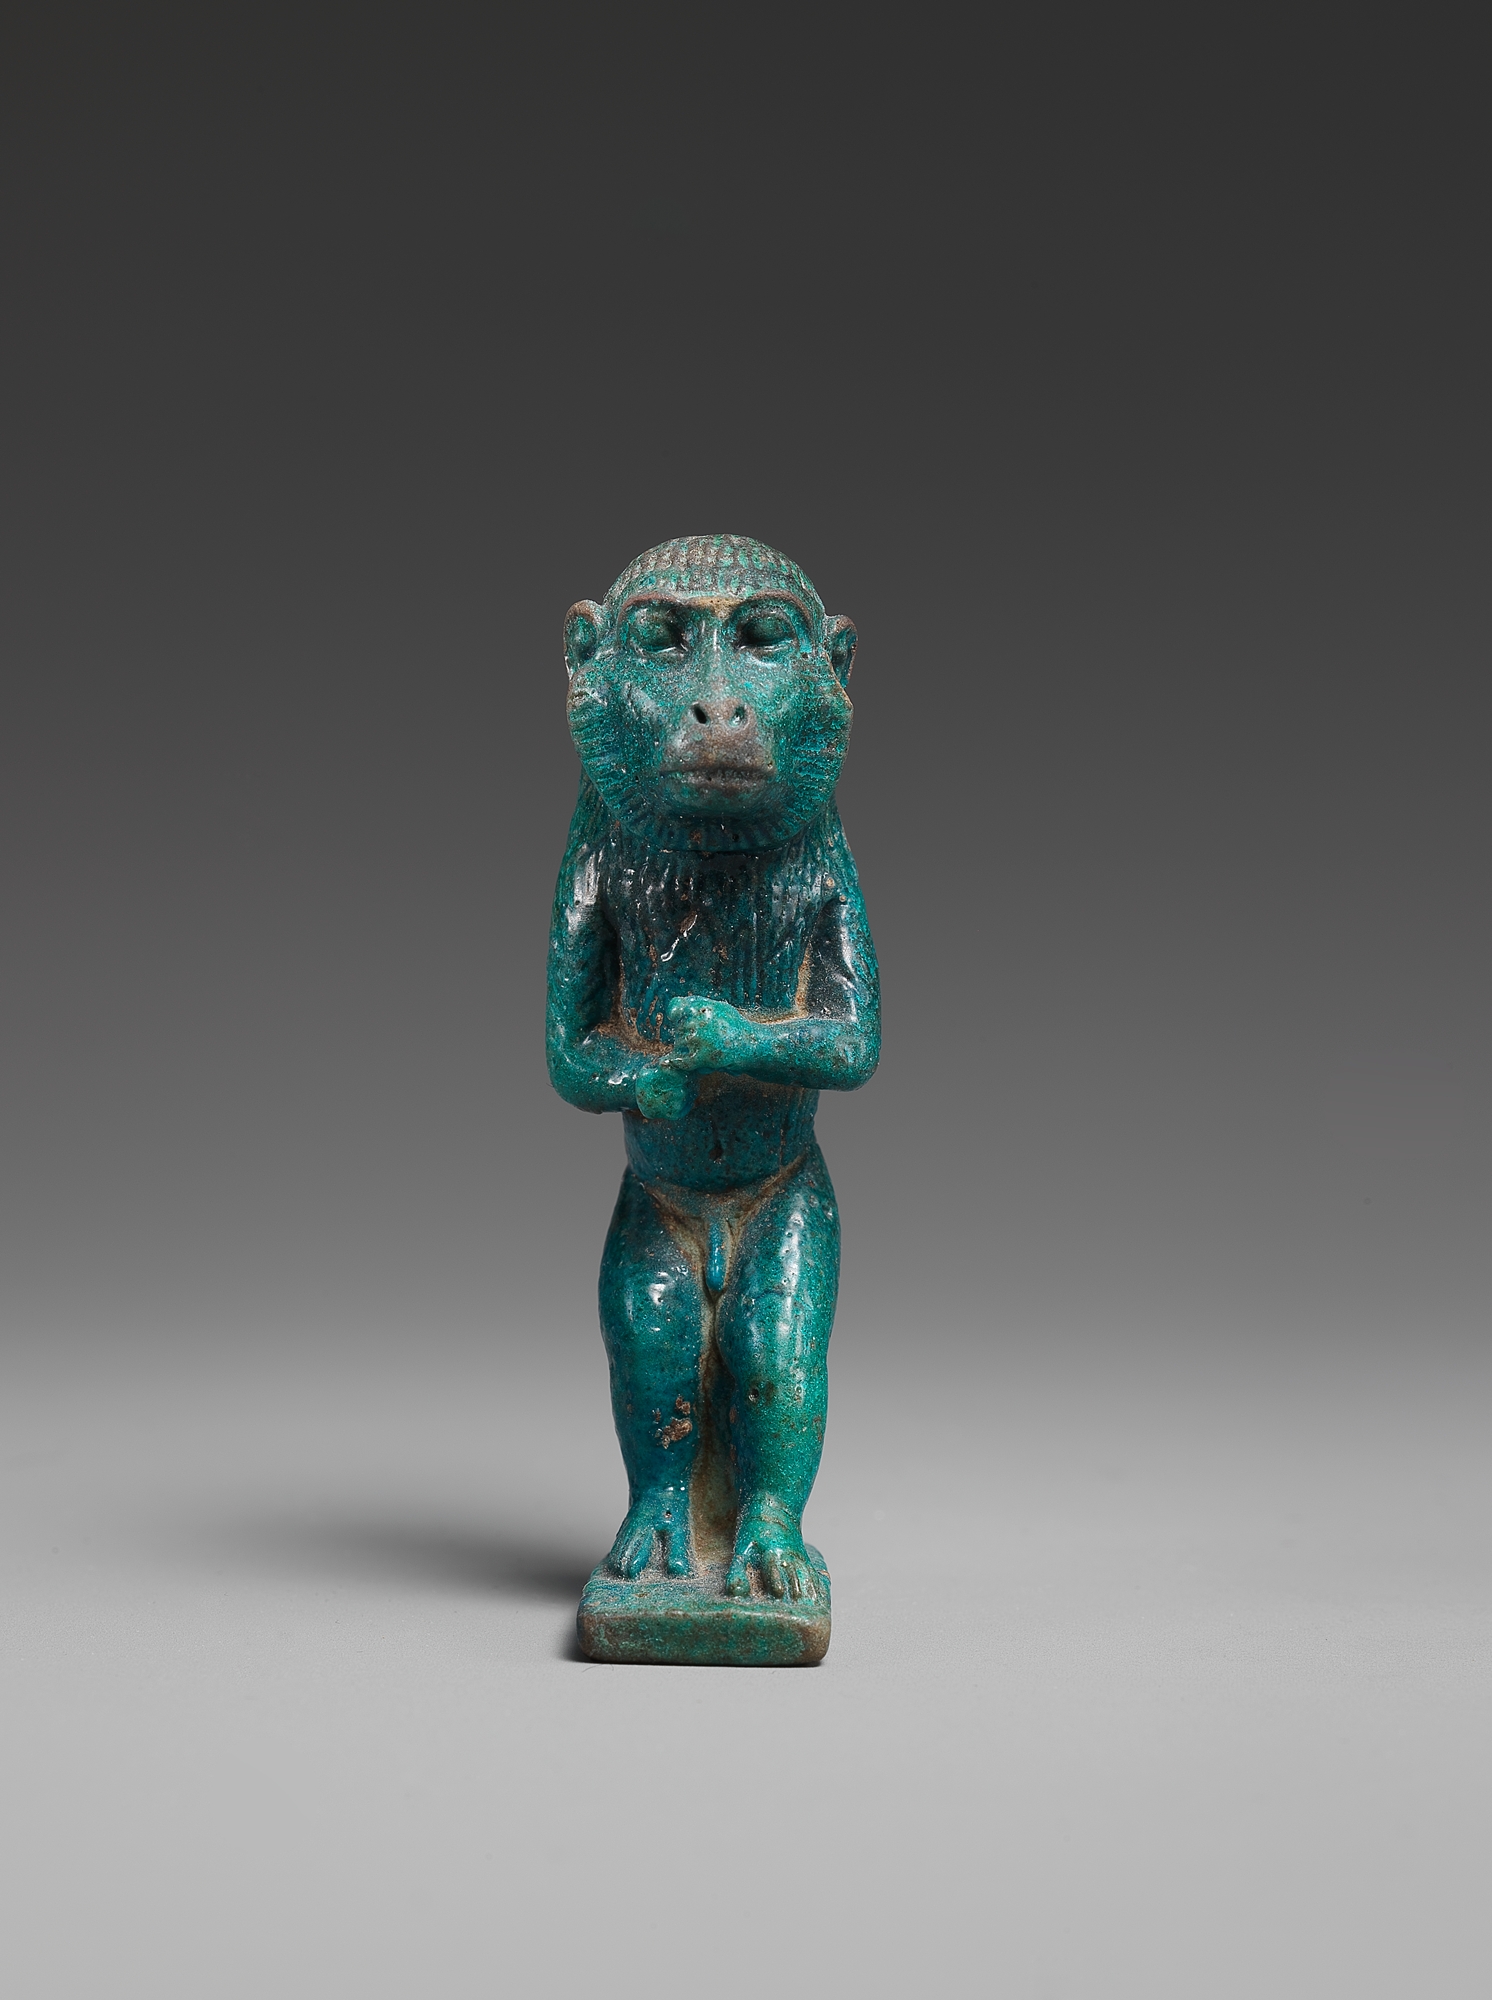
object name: amulet, monkey, serpent tail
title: Standing Monkey Amulet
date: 664-332 BCE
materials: faience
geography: egypt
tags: monkeys